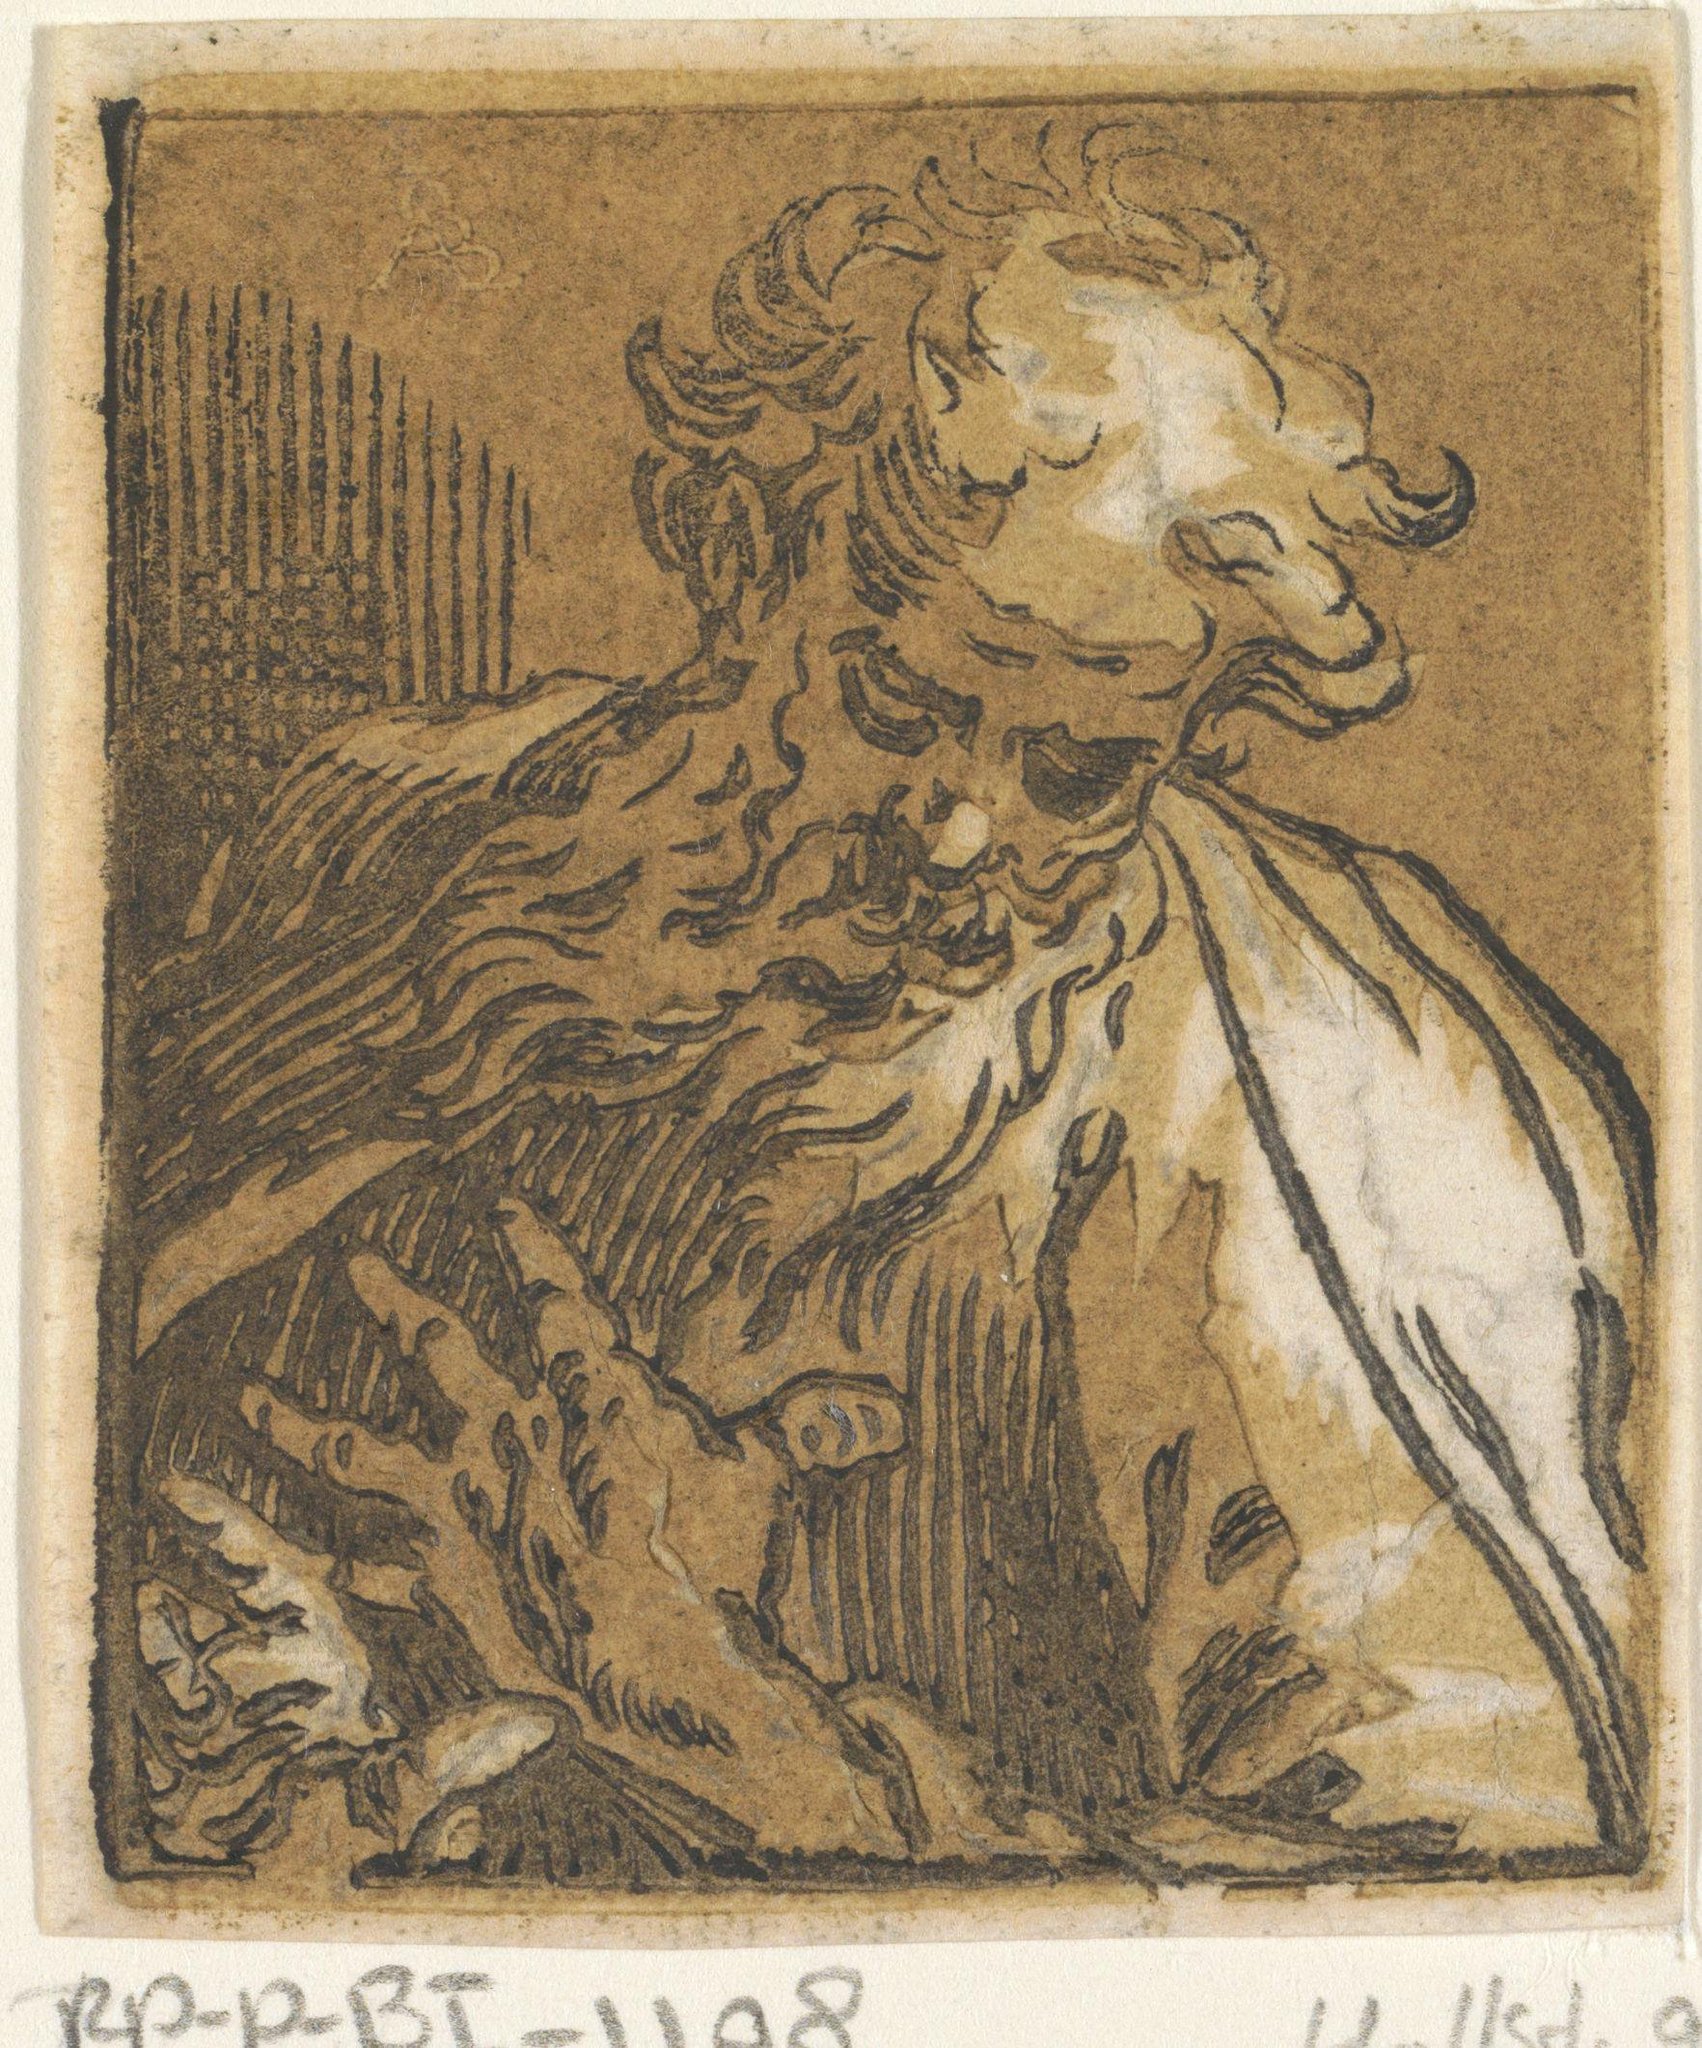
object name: print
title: Jozef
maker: Anonymous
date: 1615-1623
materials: paper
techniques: woodcut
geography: netherlands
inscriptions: collector's mark: Lugt 240